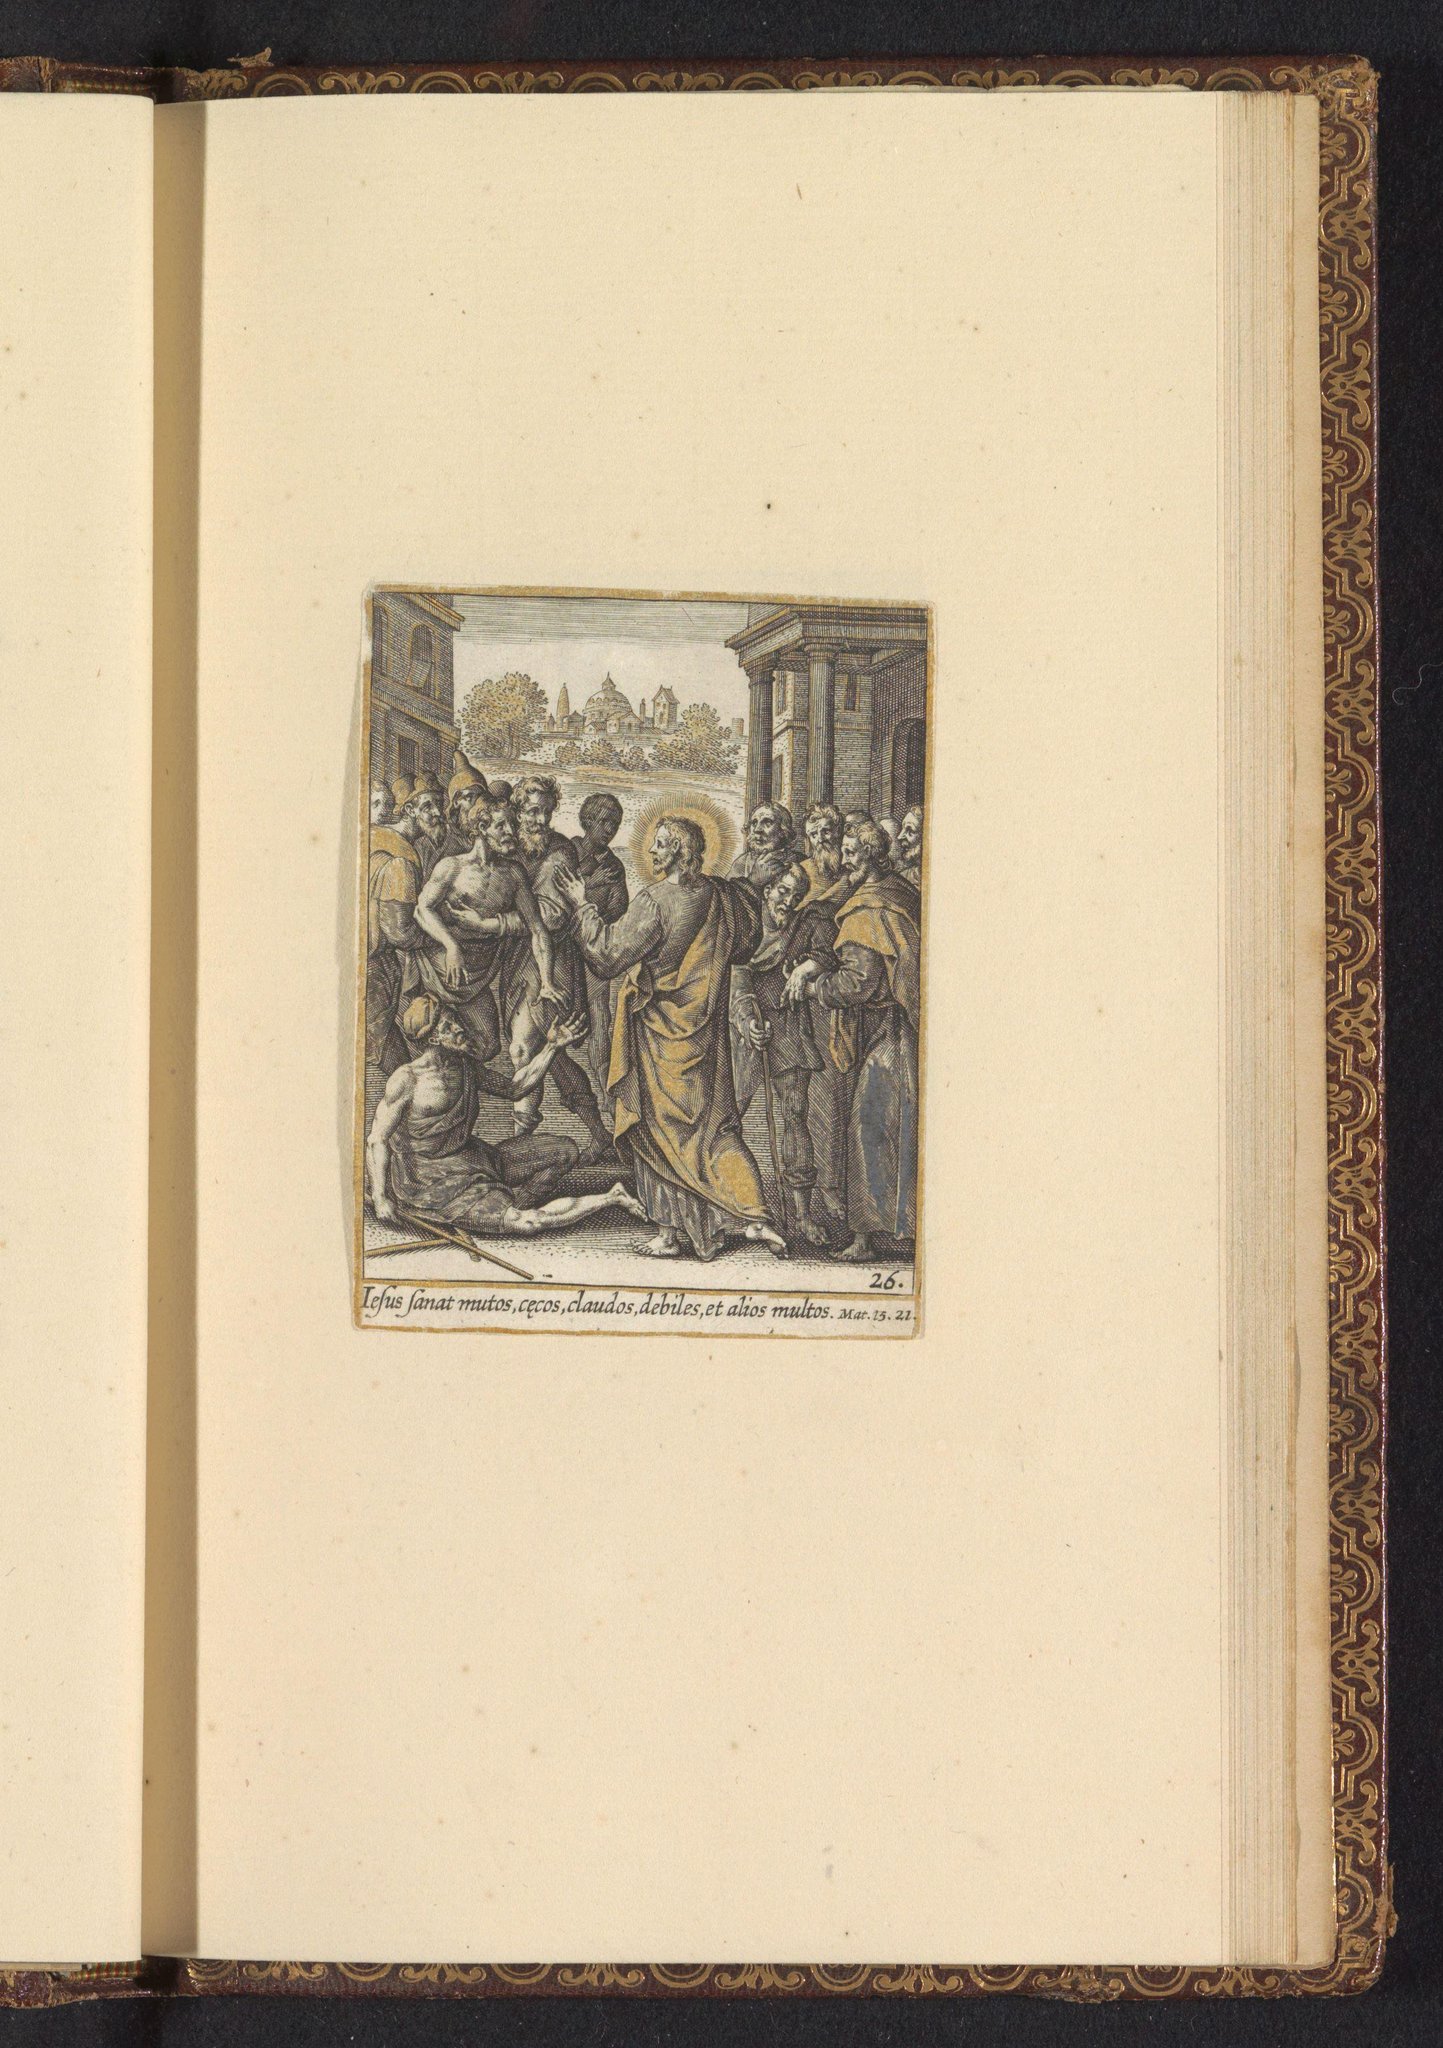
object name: print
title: Christus geneest zieken en kreupelen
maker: adriaen collaert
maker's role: draughtsman, print maker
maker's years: 1560-1618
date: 1580-1590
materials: gold, paper, silver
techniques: engraving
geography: antwerp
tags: disabilities, deformations, miracles of christ ~ healing the sick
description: Onderdeel van de prentserie over het leven van Christus: Vita Iesu Salvatoris varijs iconibus ab Adriano Collaert expressa. In prentalbum met twee reeksen van respectievelijk 34 en 25 gravures met scènes uit het leven en het lijdensverhaal van Christus. In de tijd waarin deze serie gemaakt is was 'kreupel' een generiek woord om een lichamelijke beperking aan het onderlichaam te beschrijven.